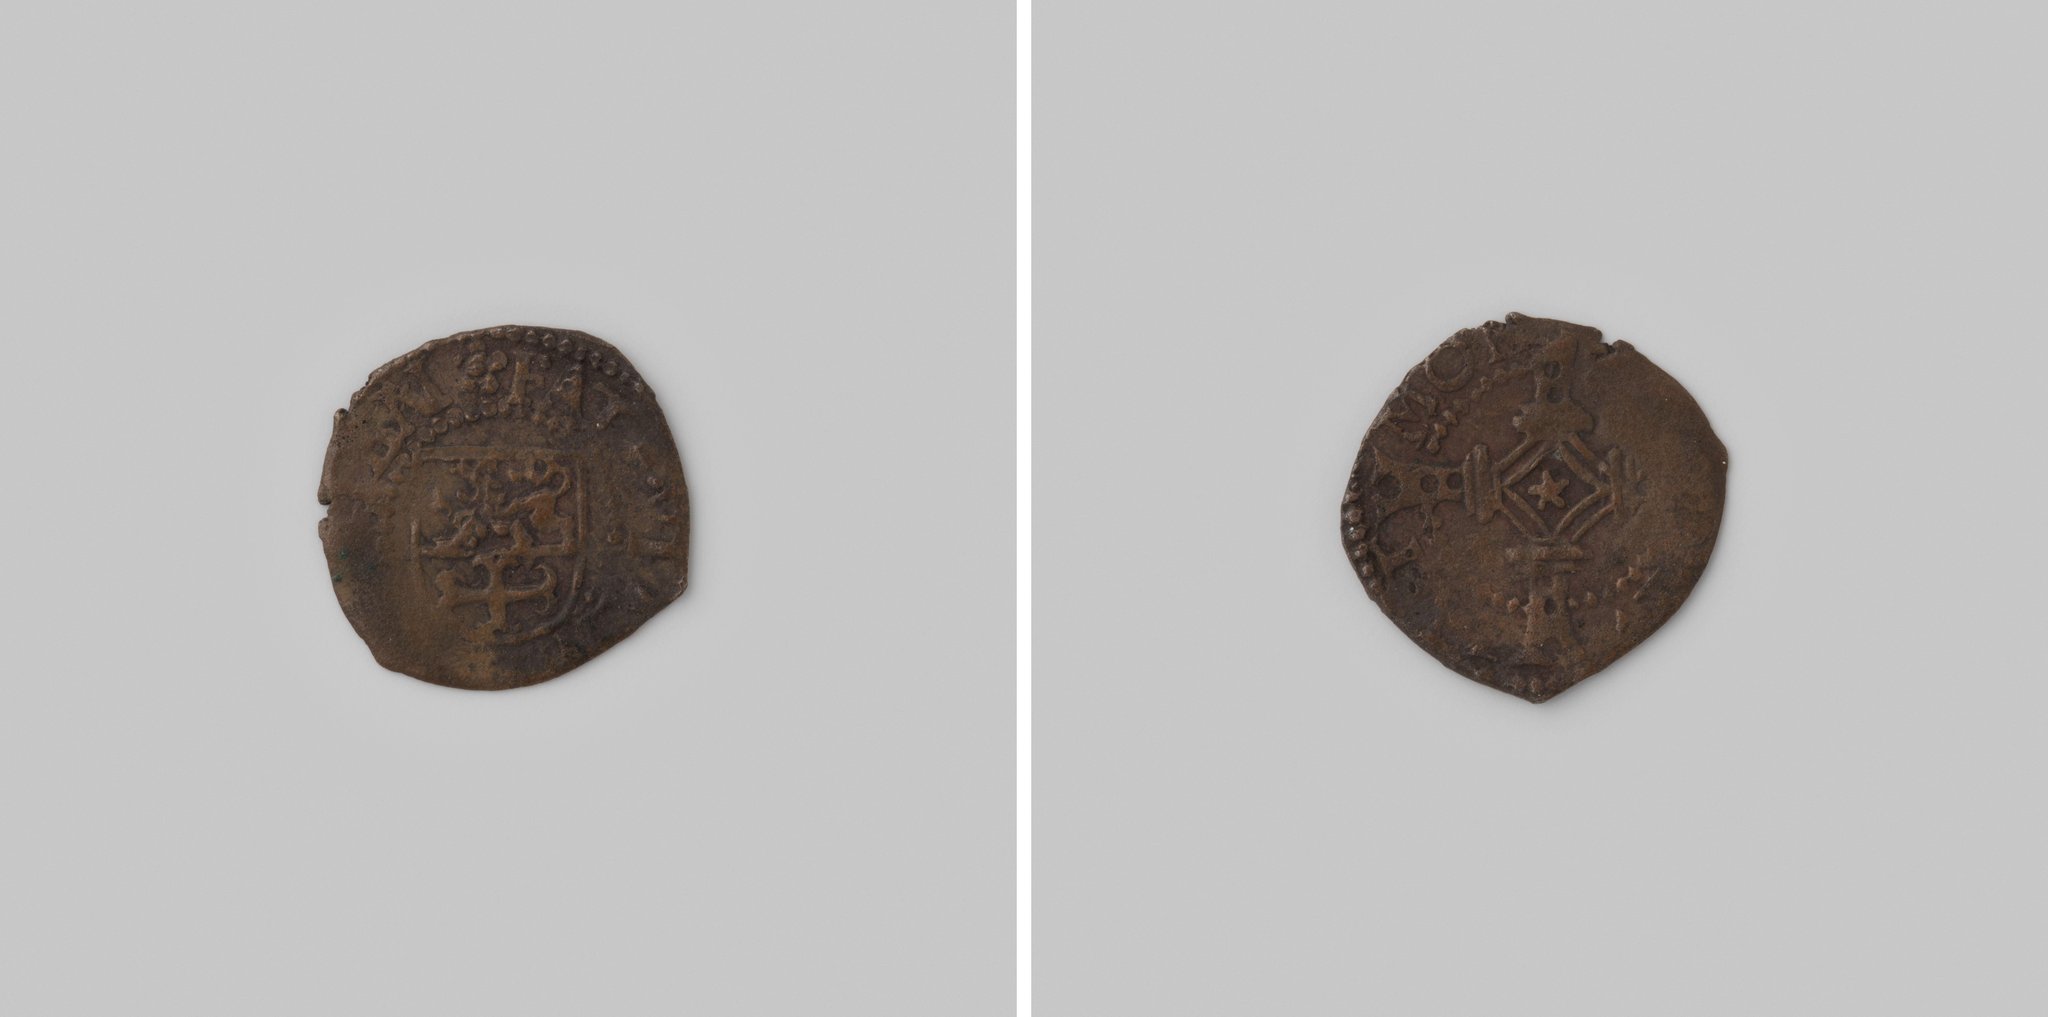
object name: coin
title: Zutphen, halve plak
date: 1582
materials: silver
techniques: striking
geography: zutphen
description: Koper-zilveren munt. Voorzijde: stedelijk wapenschild. Keerzijde: lang gevoet kruis, in het hart sterretje.